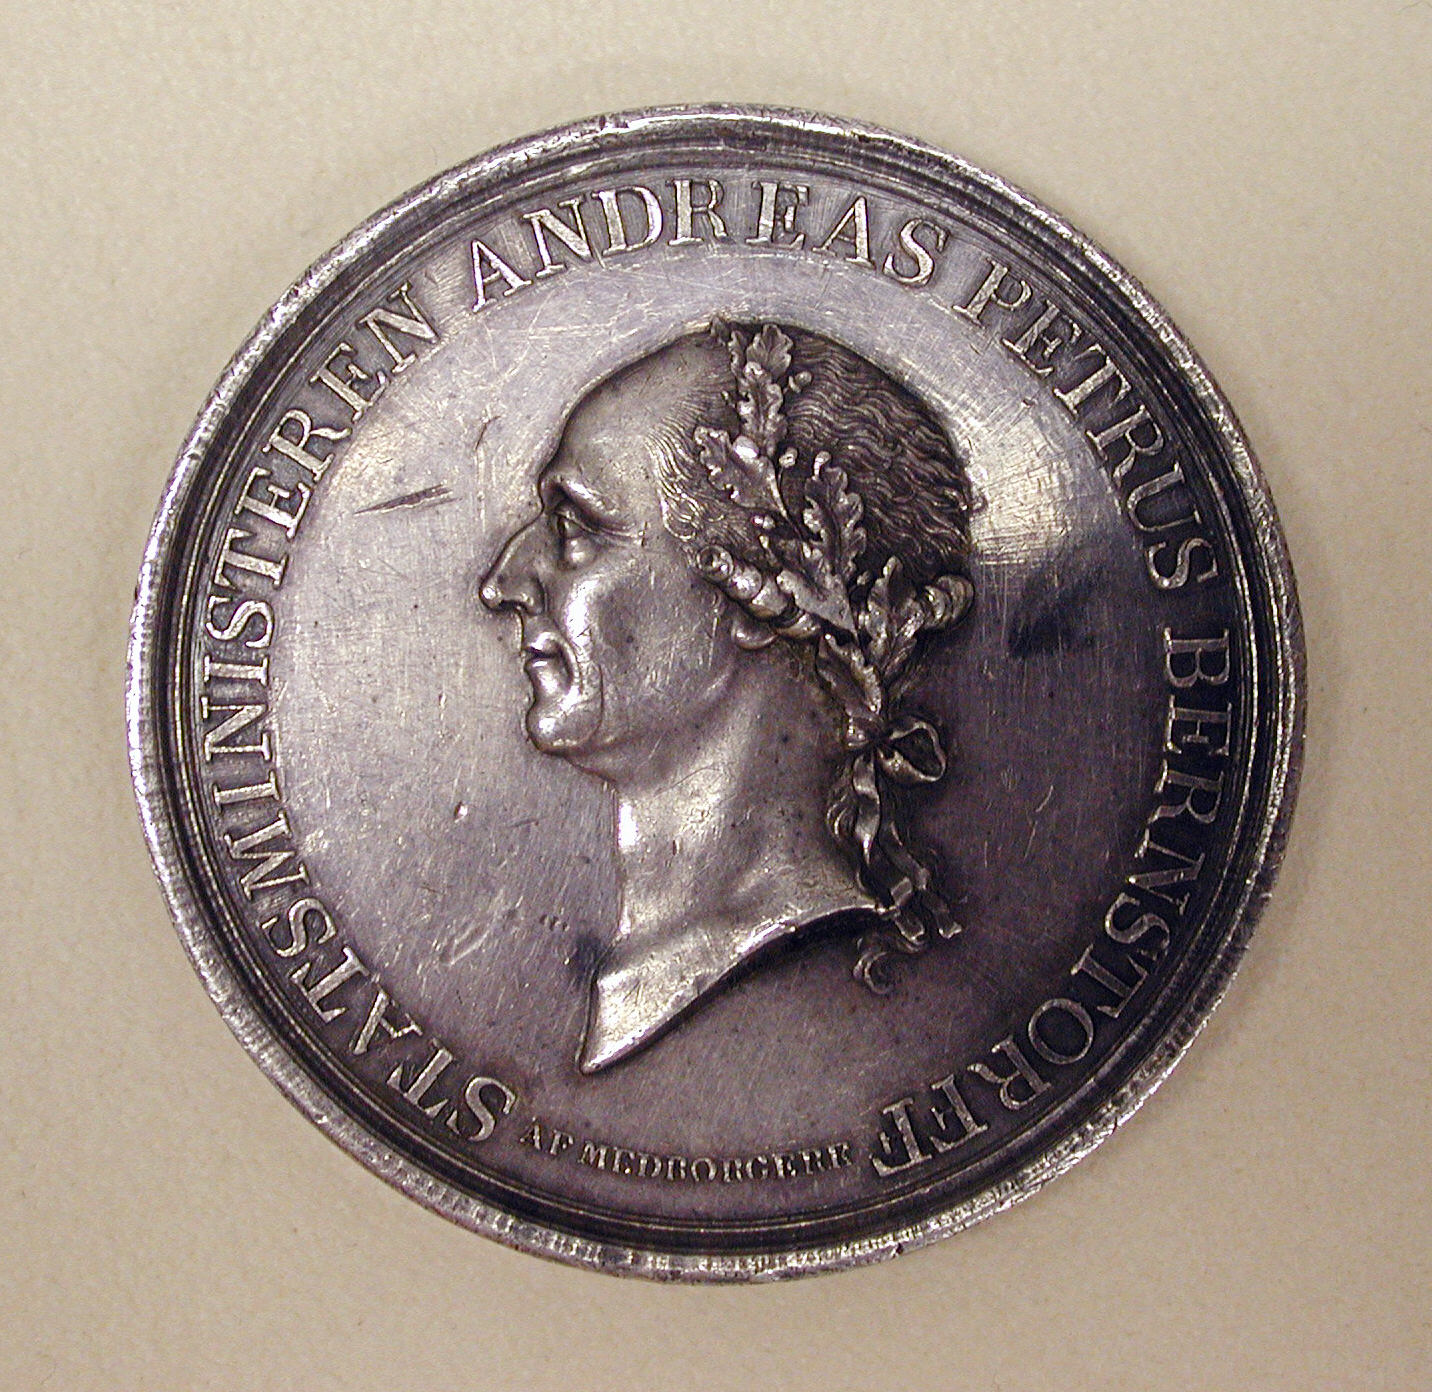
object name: medal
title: Andreas Peter Bernstorff (1735–1797), Danish Foreign Minister (1784–97)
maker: daniel jensen adzer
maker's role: artist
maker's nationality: danish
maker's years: 1708-1808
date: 1793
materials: silver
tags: men,profiles